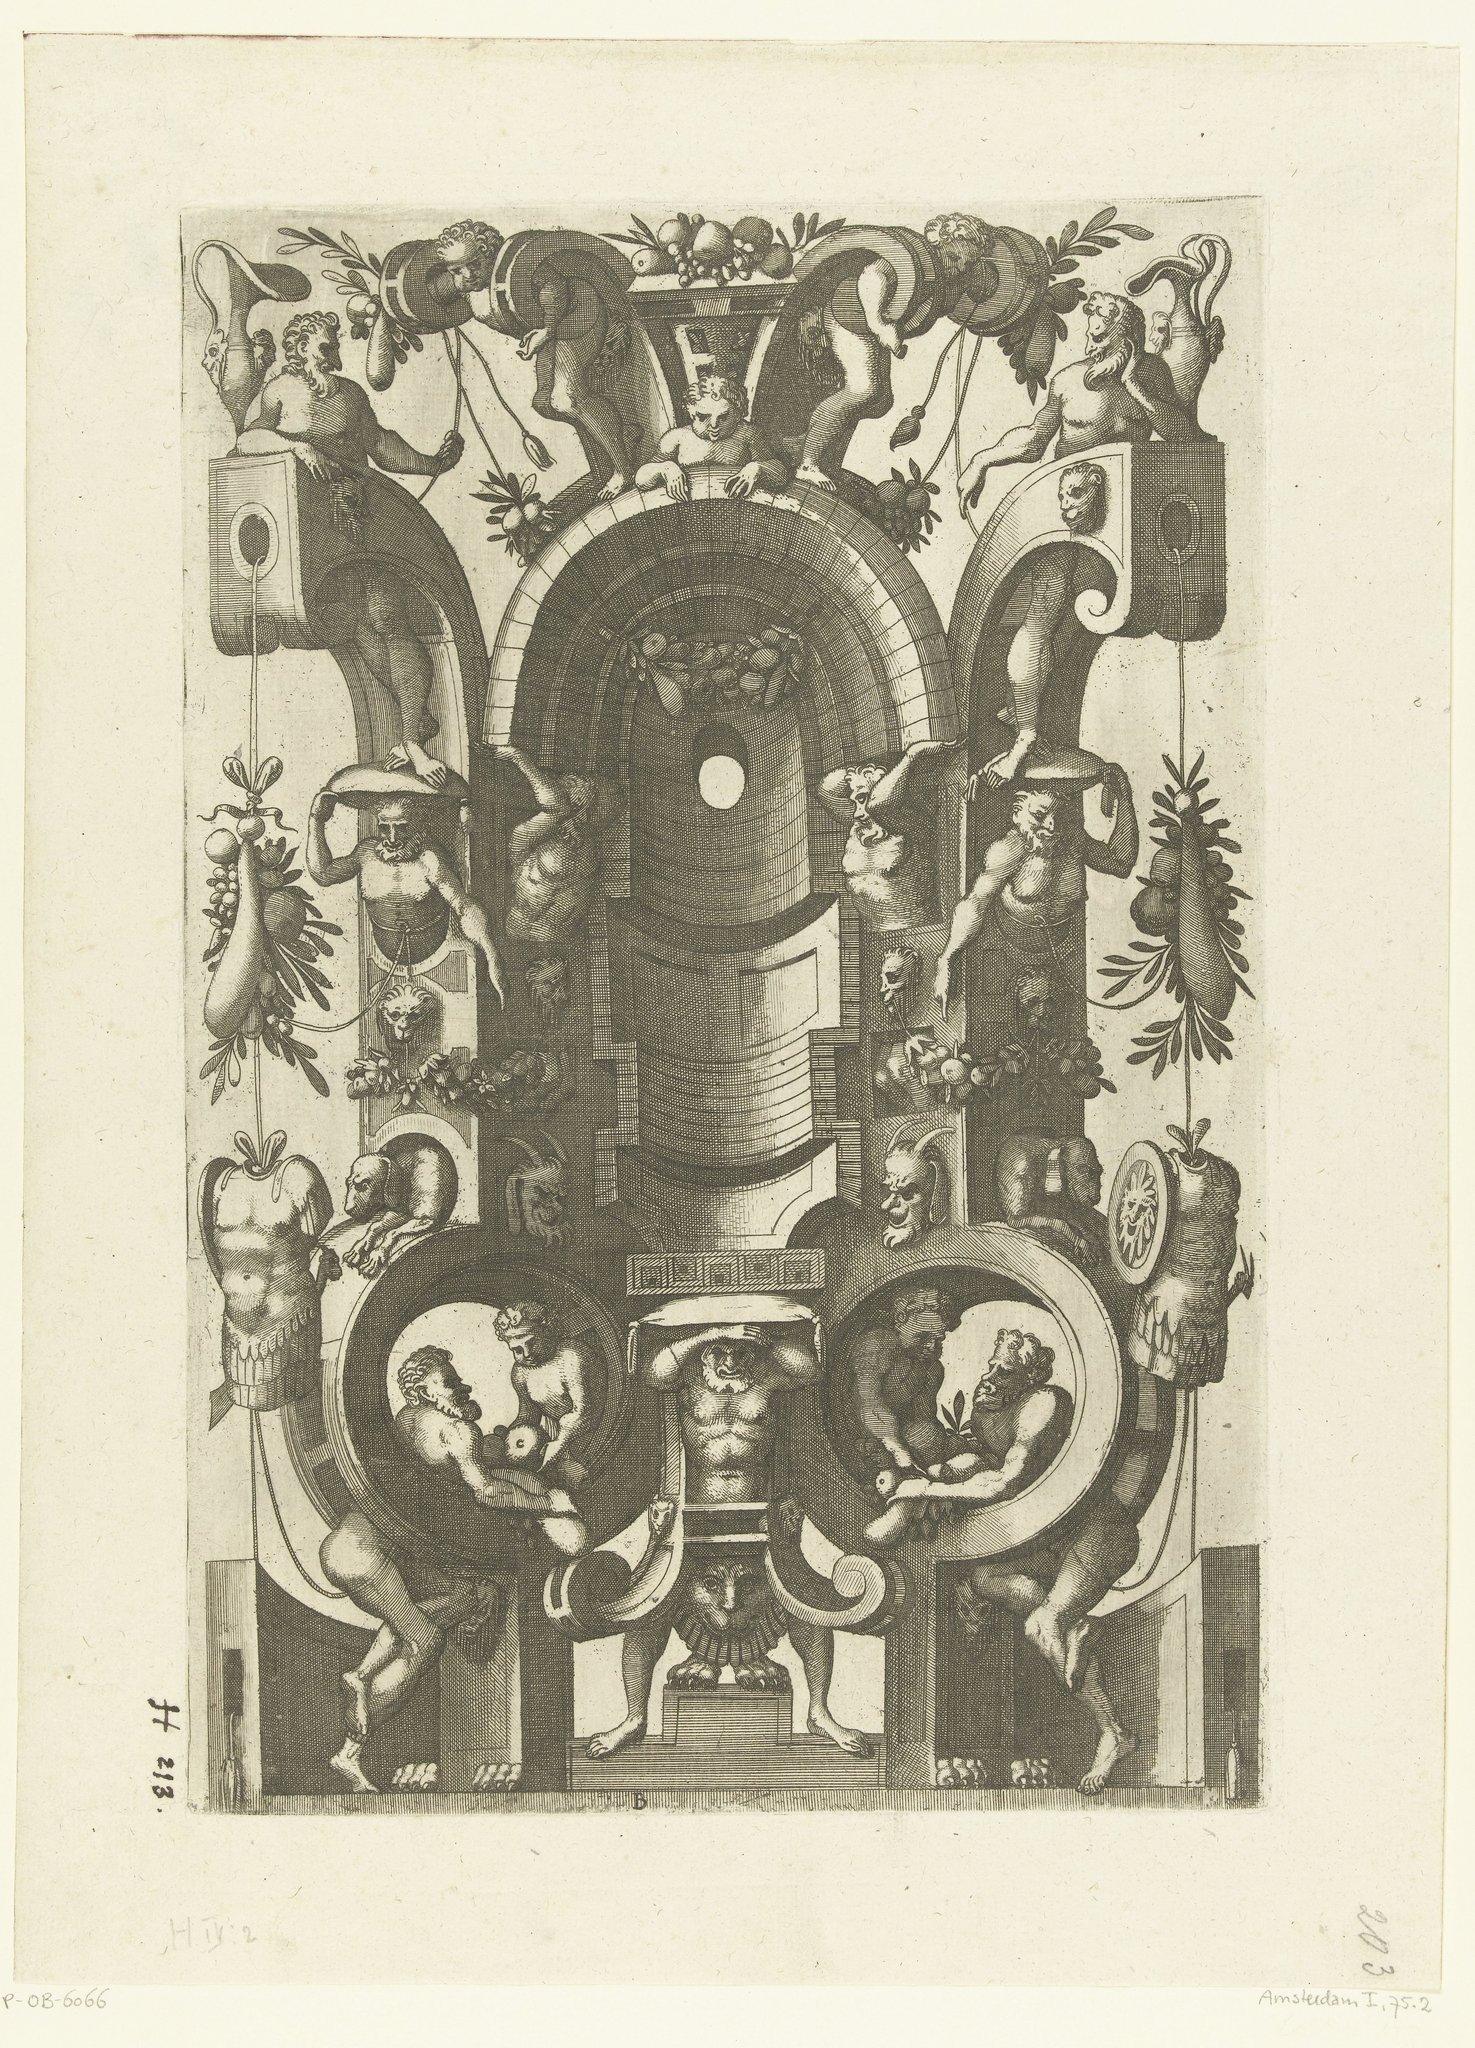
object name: print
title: Veelderleij Veranderinghe van grotissen ende Compertimenten (...)Libro Primo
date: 1556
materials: paper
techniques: etching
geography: netherlands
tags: ornament ~ grotesque, atlantes ~ architecture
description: Aan weerszijden van atlant rolwerk met voluut waar een man doorheen leunt. In de voluut een kind. Blad B afkomstig uit serie van 12 bladen, genummerd A-M van vlakdecoraties met grotesken met rolwerk, saters, guirlandes, trofeeën, dieren en fantasiewezens